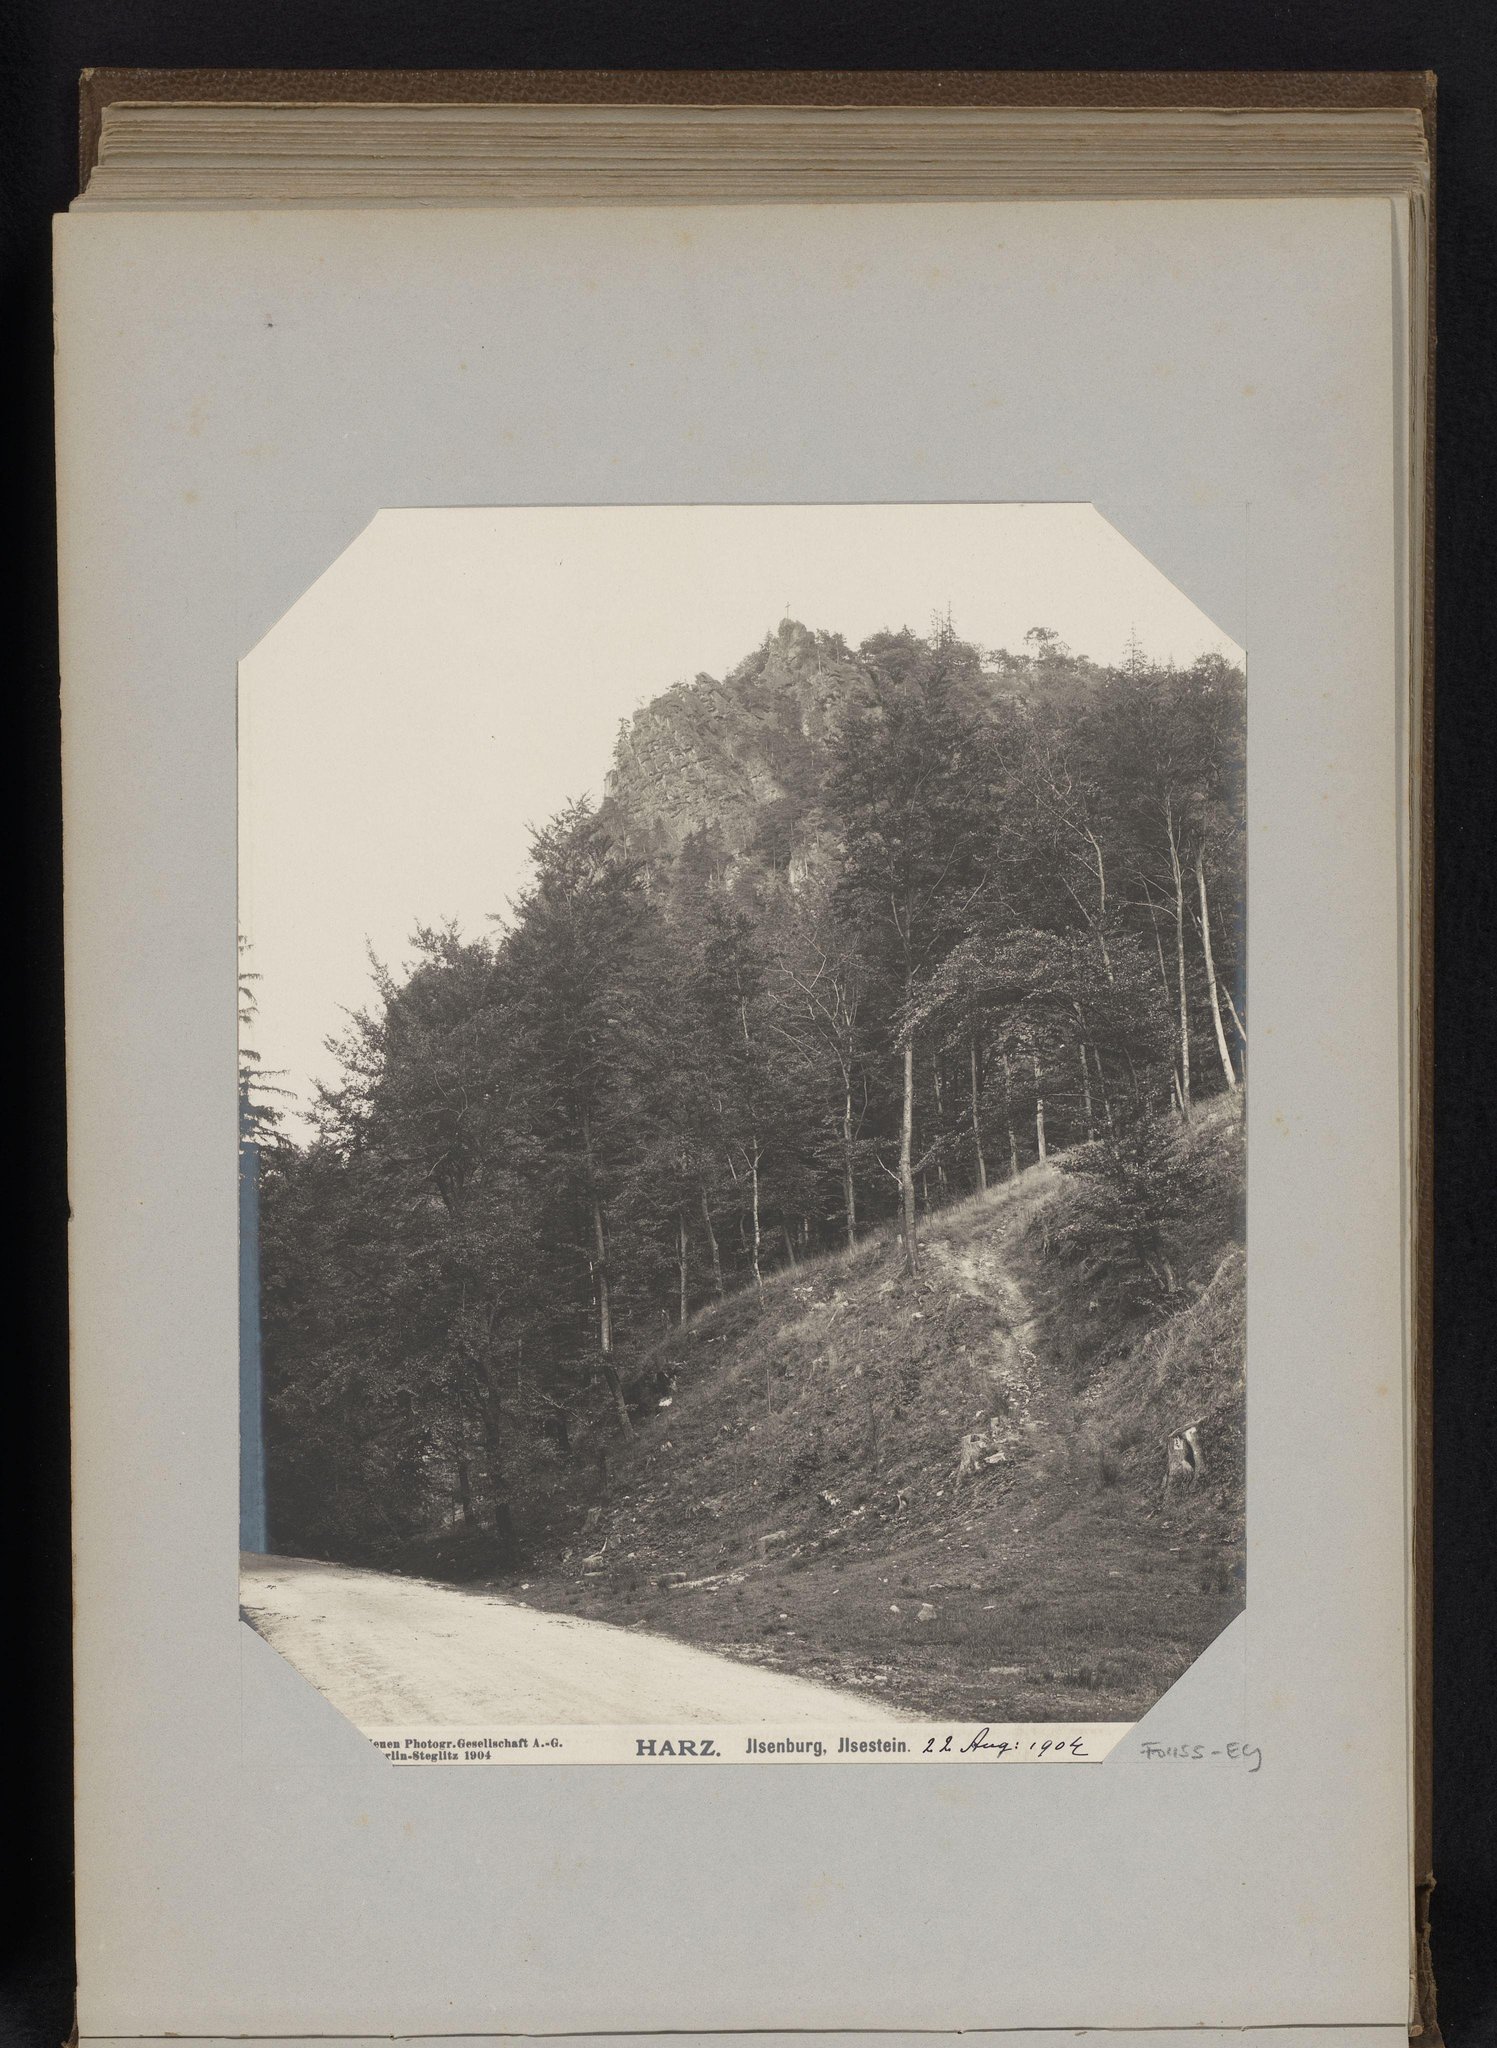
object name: album leaf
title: Gezicht op de rotsformatie Ilsestein te Ilsenburg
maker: Anonymous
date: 1904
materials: photographic support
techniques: gelatin silver print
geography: ilsenburg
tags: rock-formations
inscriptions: date: ‘22 Aug: 1904’, inscription: ‘Verlag der Neuen Photogr. Gesellschaft A.-G./ Berlin-Steglitz 1904/ Harz. Ilsenburg, Ilsestein/ 1641’